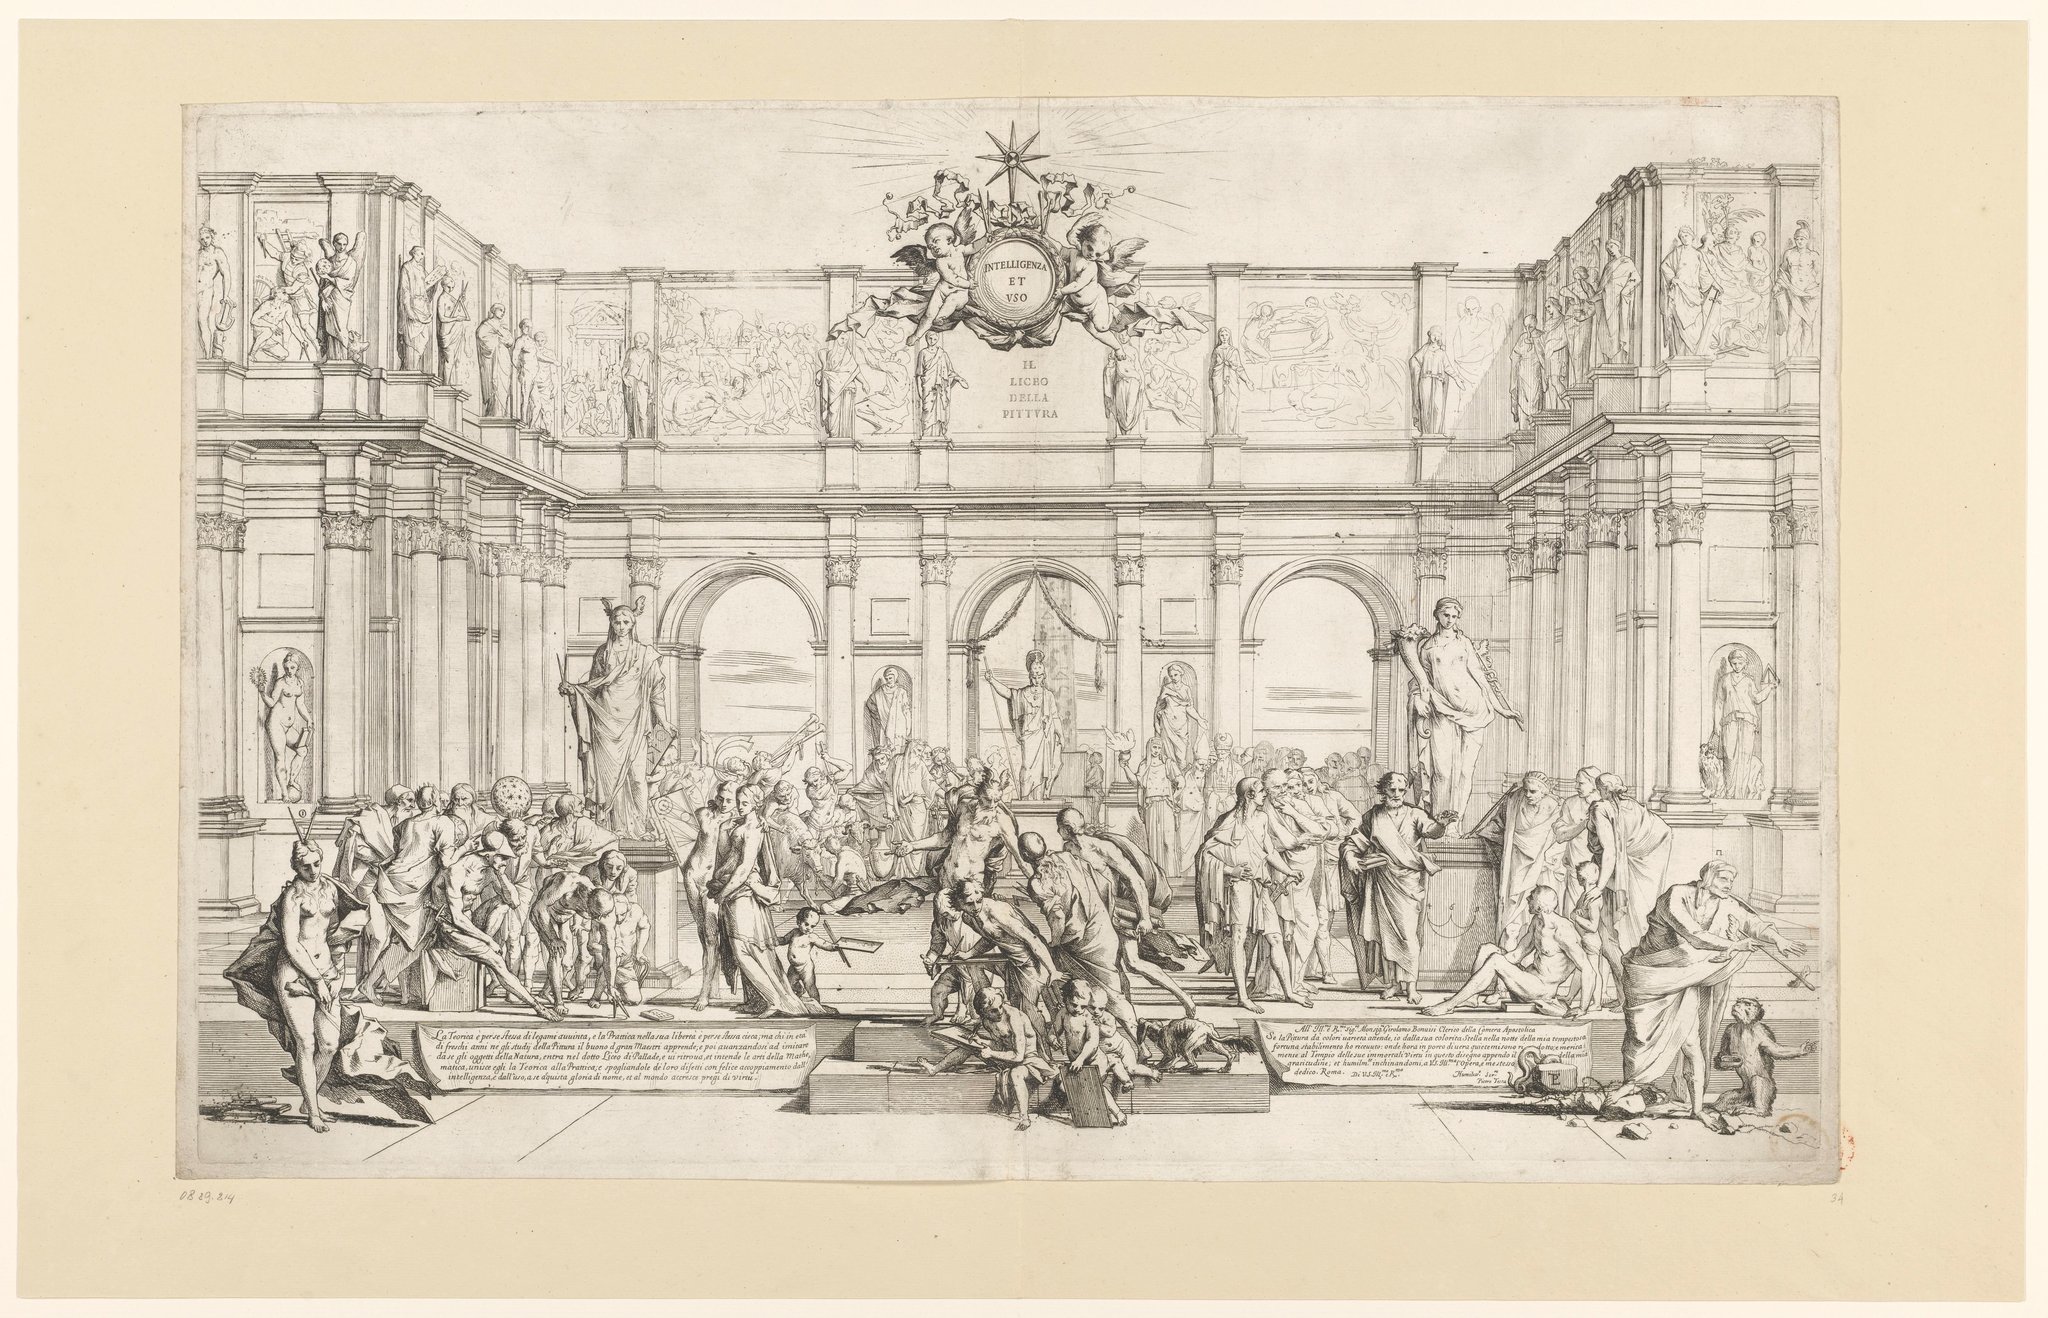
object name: print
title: Academie van Schilderkunst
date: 1621-1650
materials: paper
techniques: etching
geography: italy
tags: piece of sculpture, reproduction of a piece of sculpture, portrait, self-portrait of artist, academy, association of artists, science and technology (+ portrait of scholar, scientist)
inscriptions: collector's mark: Lugt 240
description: Gezicht op een binnenplaats met drie groepen kunstenaars die imitatie, observatie en perfectie representeren. De kunstenaars verschijnen voor wetenschappers. Geheel links staat de personificatie van de theorie. Geheel rechts staat de personificatie van de praktijk met een aap, symbool voor de im itatie. Ze grijpt blind weg van de voorstelling. Tussen de figuren staan verschillende sculpturen. Links- en rechtsonder papieren met tekst. Midden boven twee putti die een medaillon met tekst dragen: 'intelligenza et uzo'.